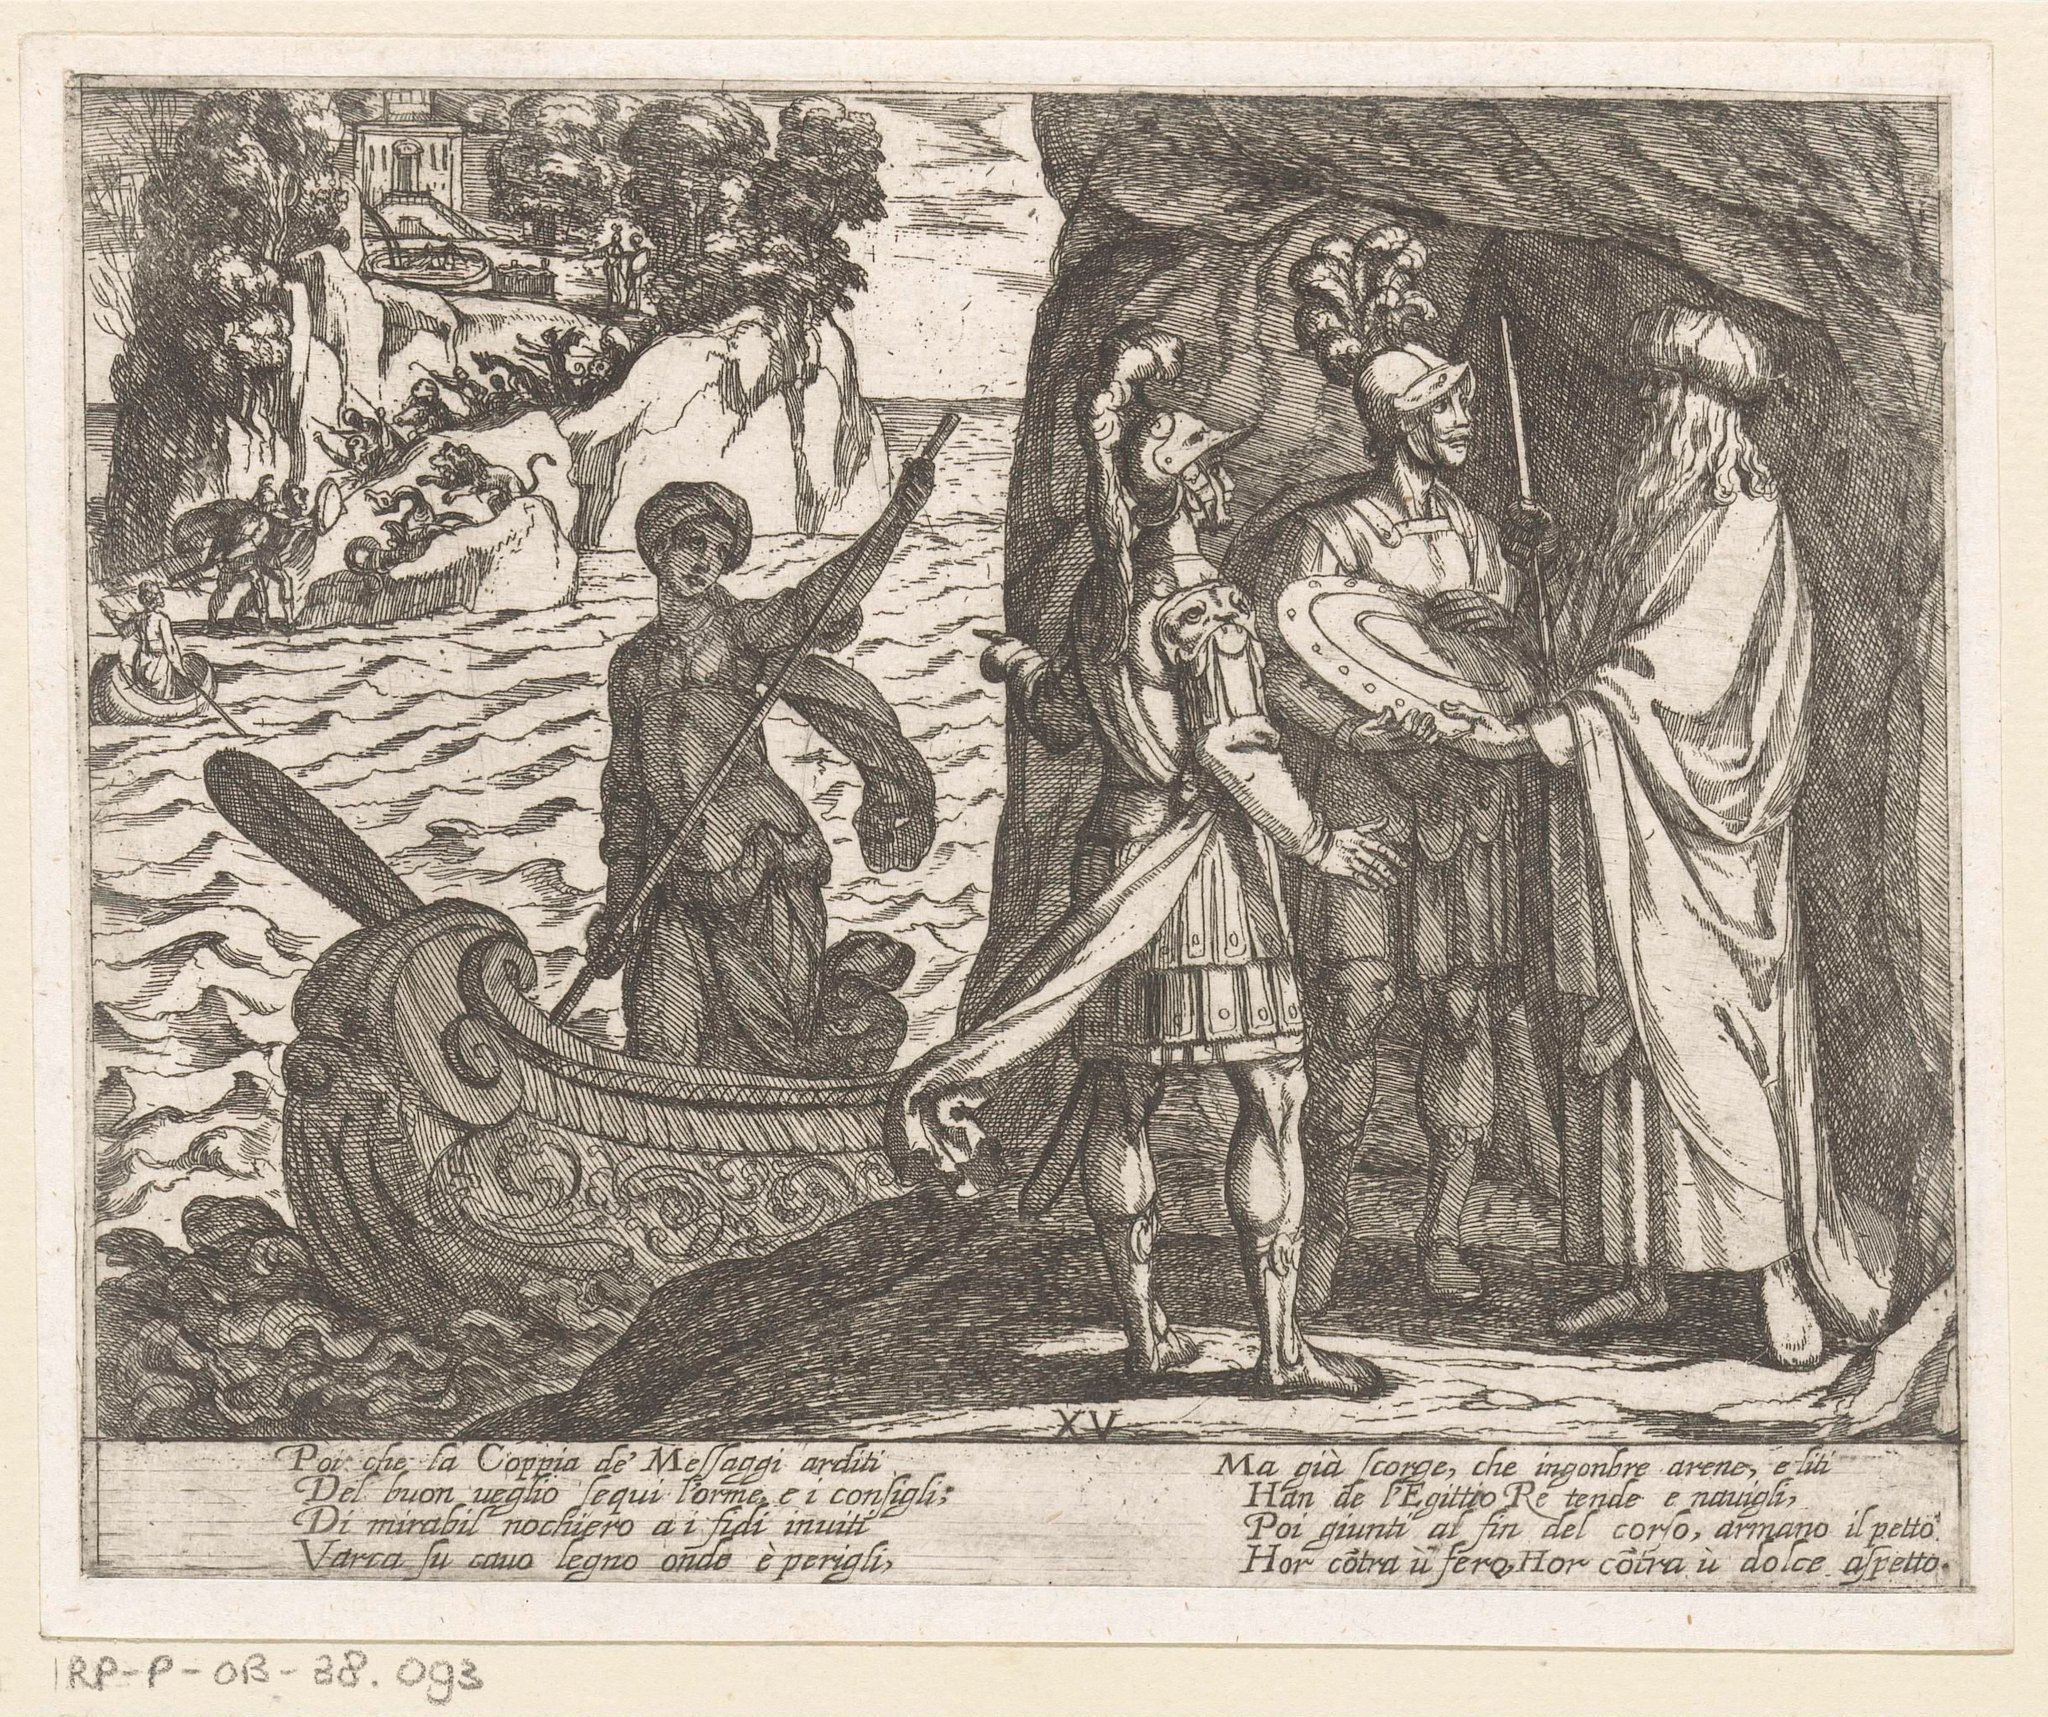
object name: print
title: Illustratie bij Canto XV van Tasso's 'Gerusalemme Liberata'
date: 1565-1630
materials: paper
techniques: etching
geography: vatican city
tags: sorcerer, magician, wizard, warlock, militant proselytizing: religious war, crusade, etc., (scenes from) specific works of literature: tasso, gerusalemme liberata, knight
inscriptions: collector's mark: Lugt 240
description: Deze prent maakt deel uit van een reeks van twintig prenten (+ opdracht) met voorstellingen van scènes uit Tasso's 'Jeruzalem verlost', een episch gedicht geschreven door de Italiaanse dichter Torquato Tasso en voor het eerst gepubliceerd in 1581. Het verhaal vertelt grotendeels in fictie over de Eerste Kruistocht waarin de christenen, geleid door Godfried van Bouillon, de strijd aangaan met de moslims om het Beleg van Jeruzalem.